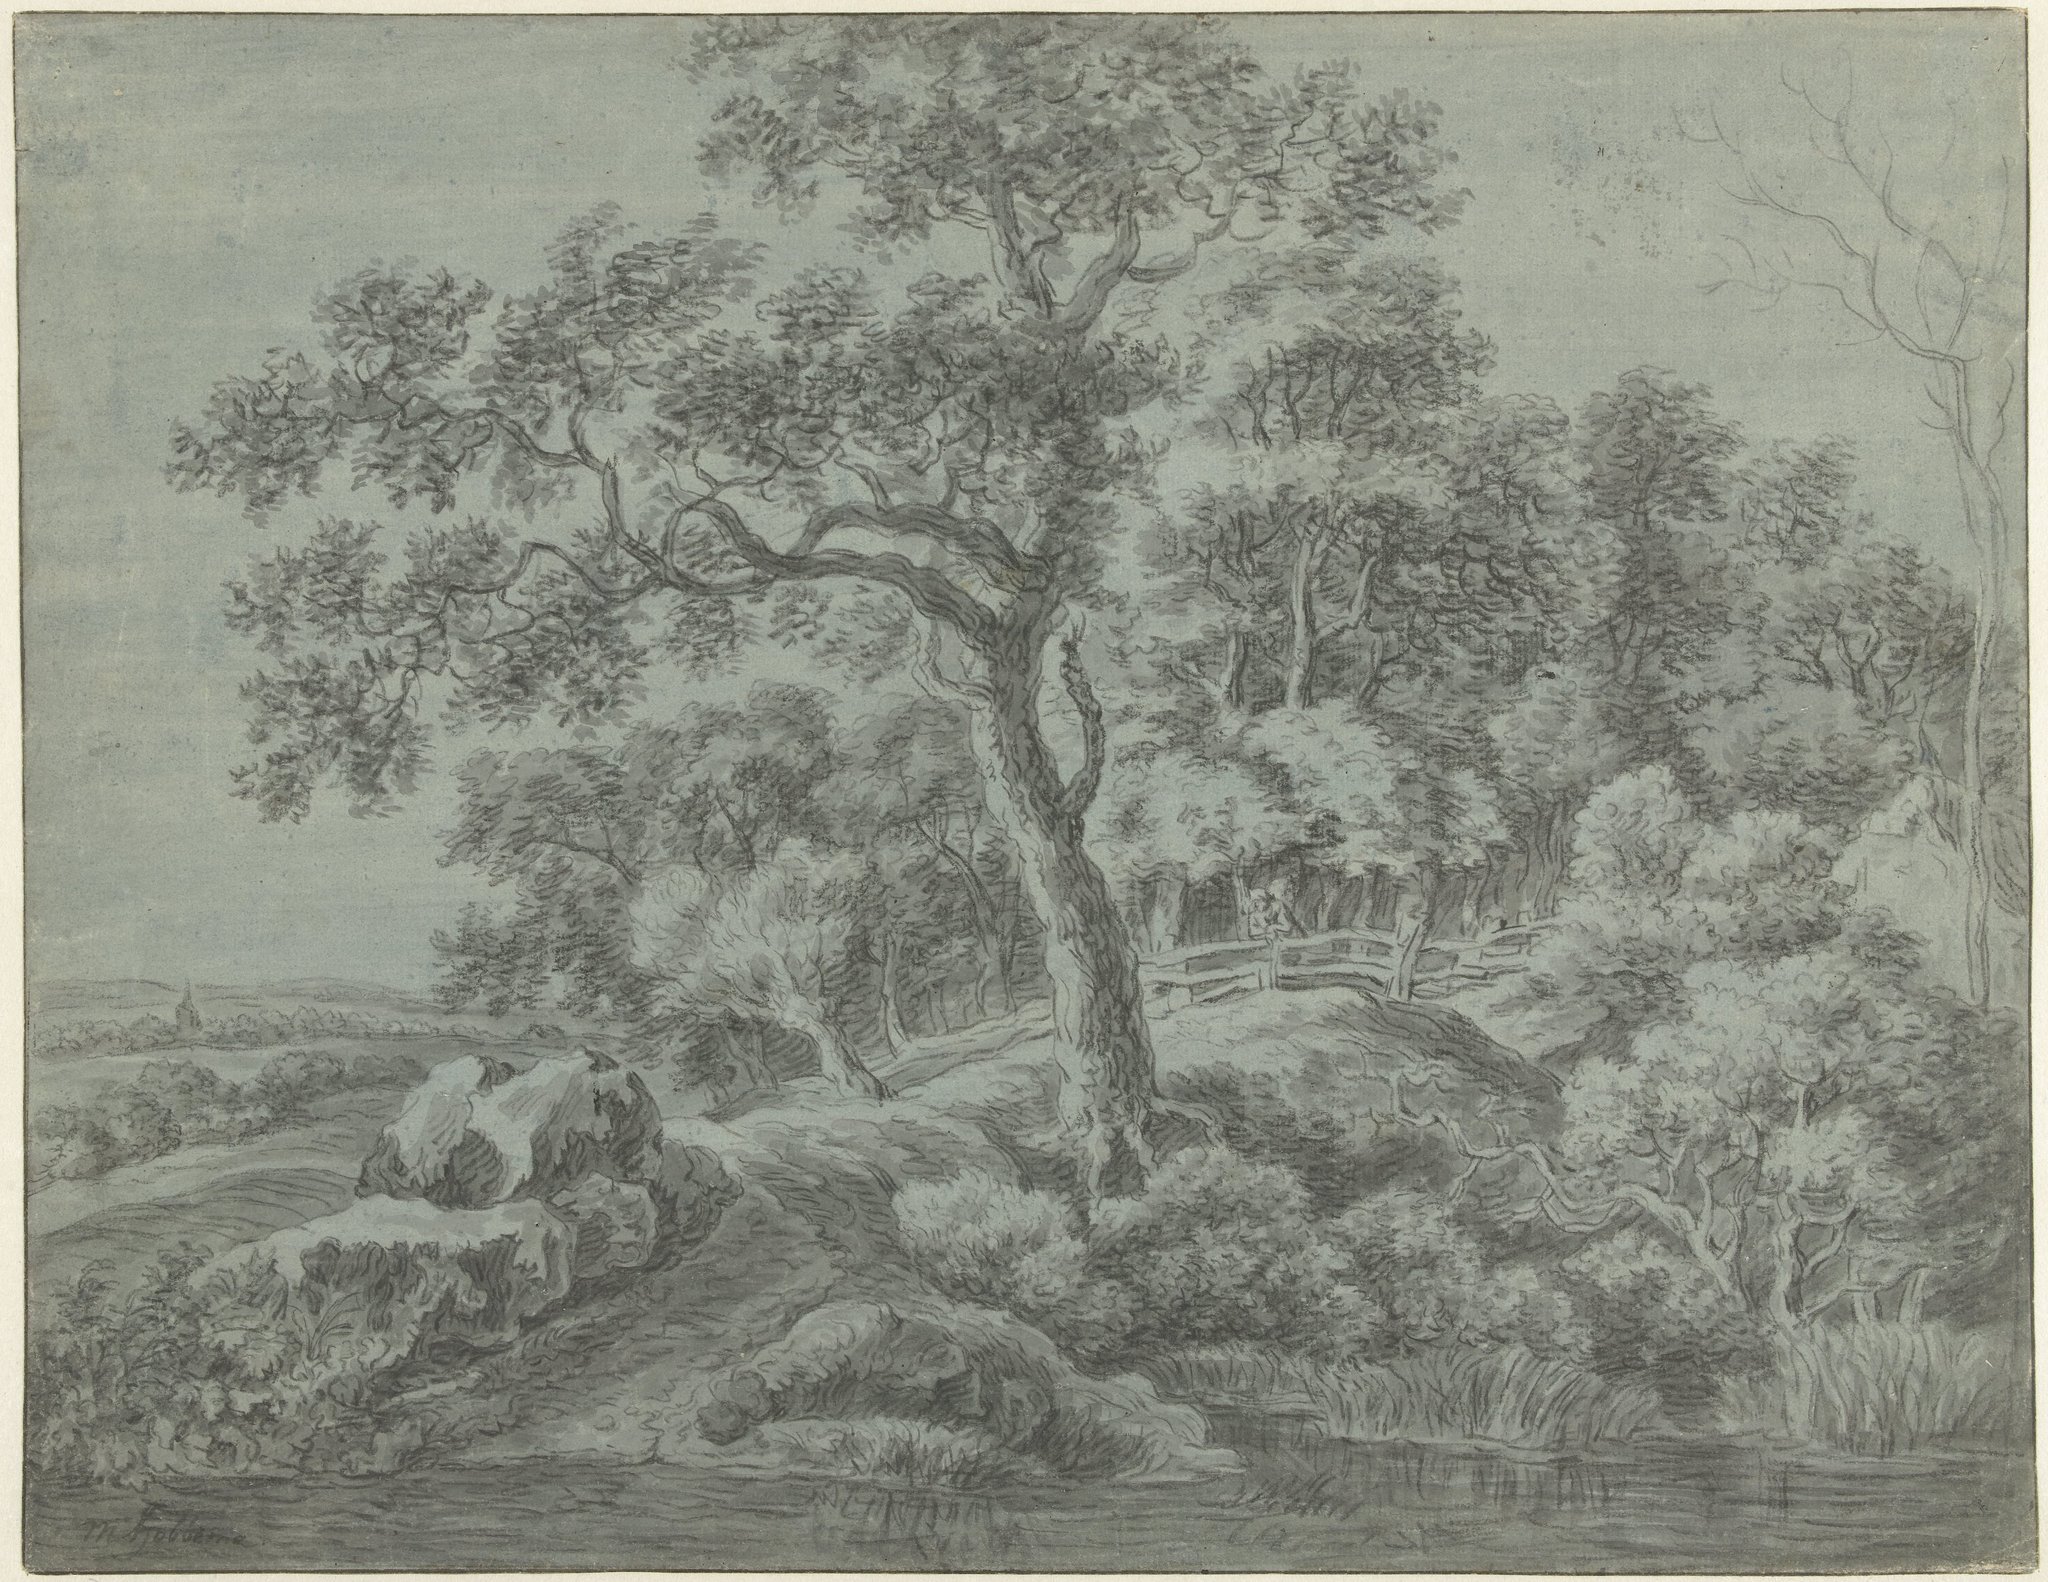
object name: drawing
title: Landschap met bomen aan water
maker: egbert van drielst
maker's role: draughtsman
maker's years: 1745-1818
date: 1755-1818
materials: chalk, paper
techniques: brush